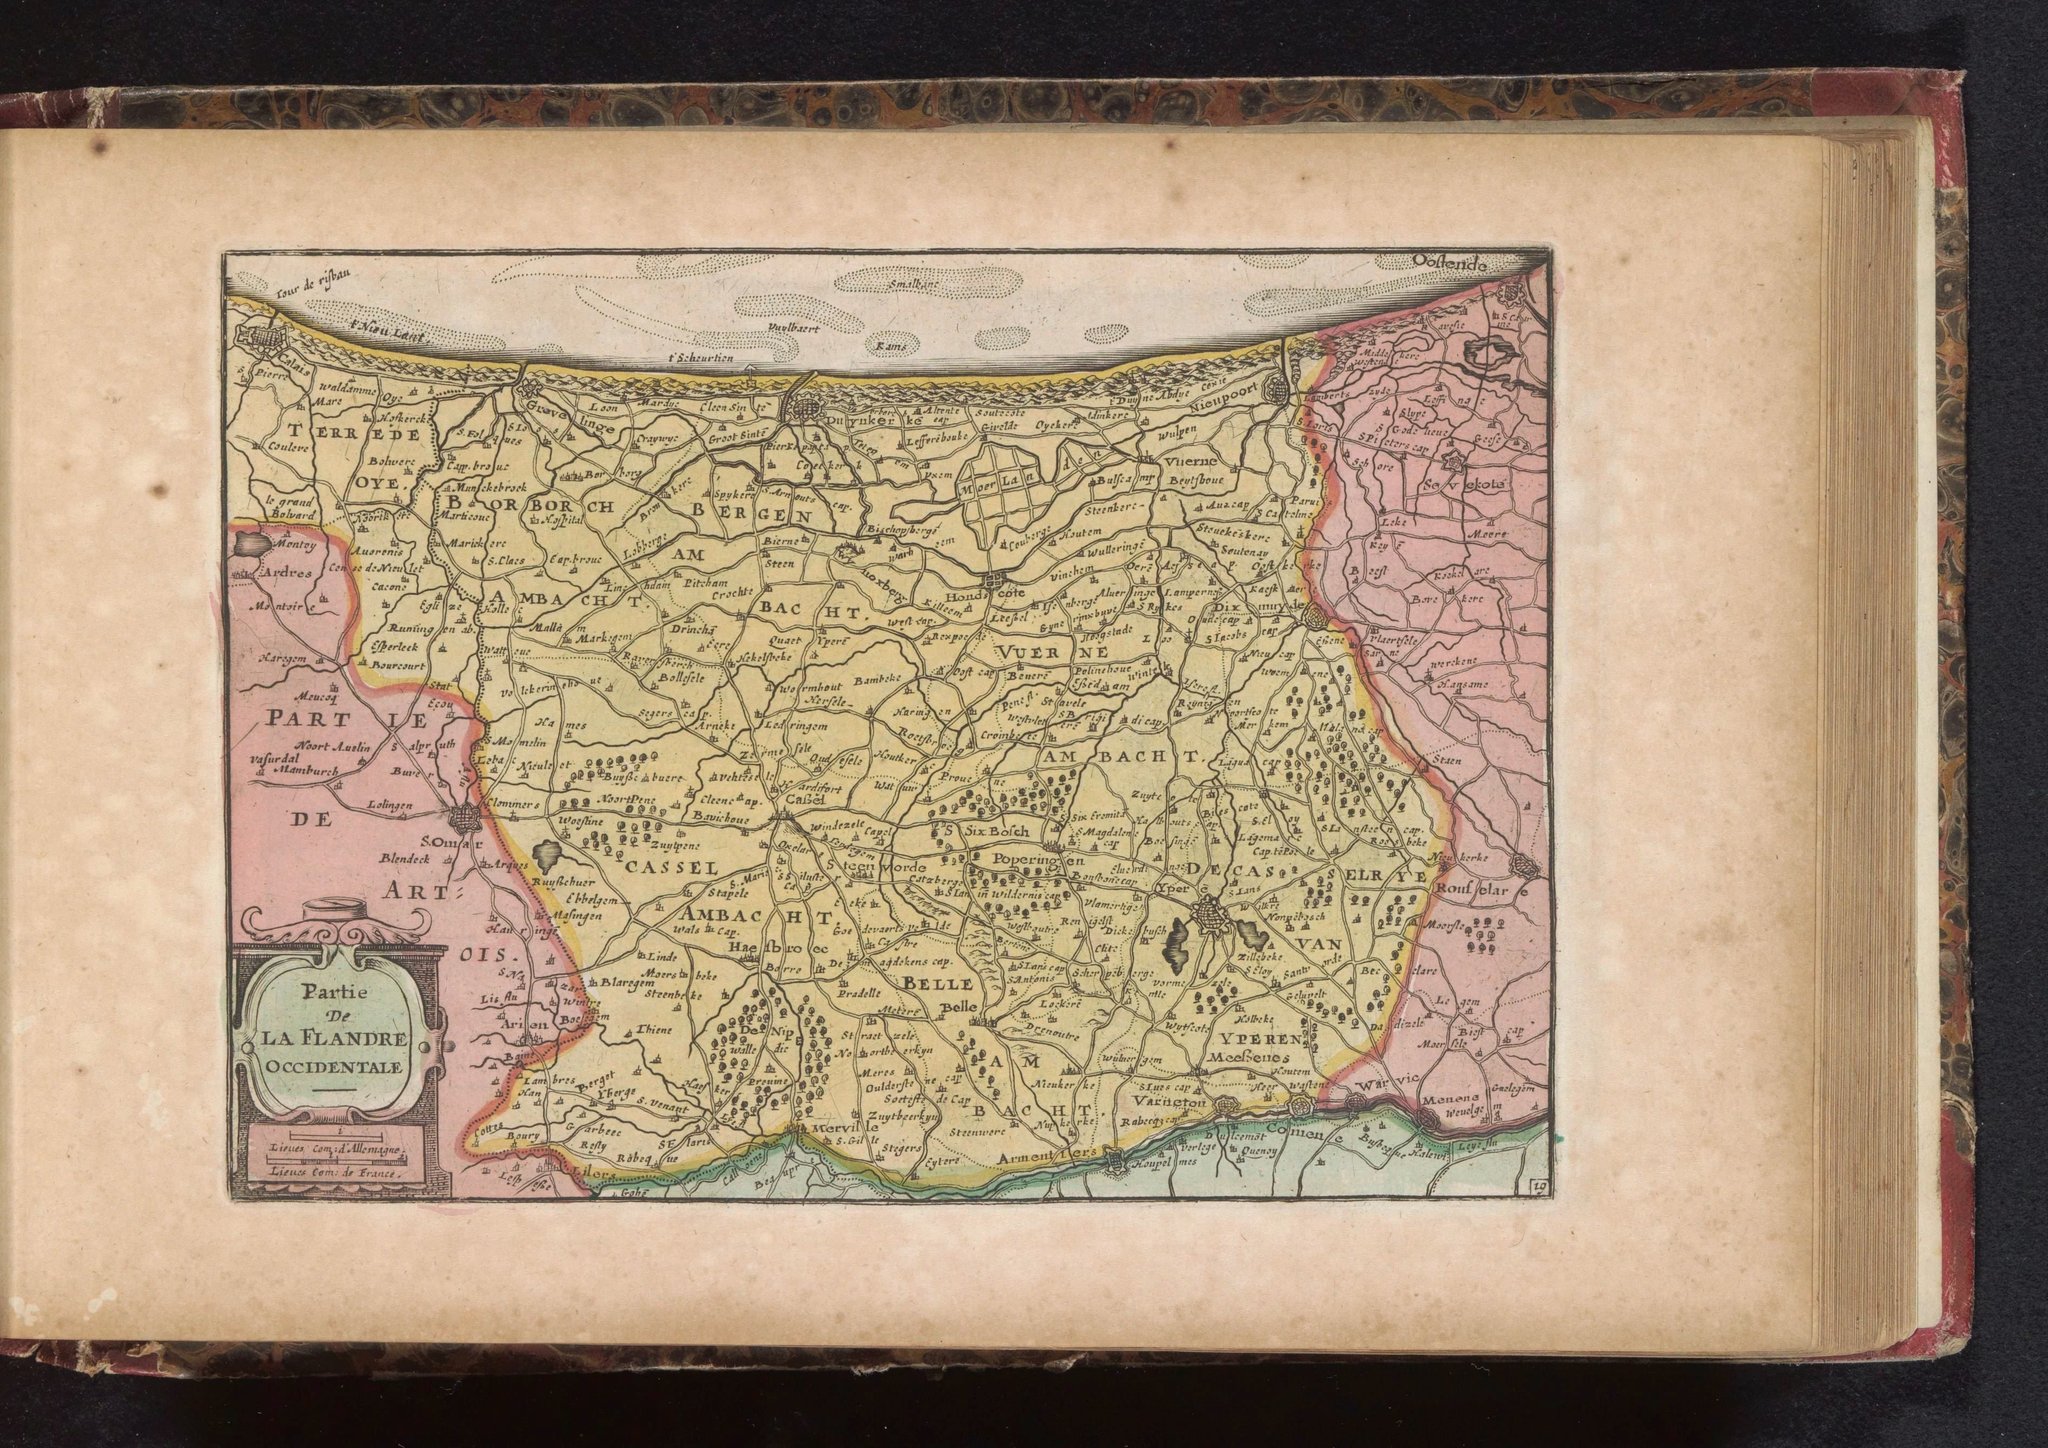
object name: map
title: Partie de la Flandre Occidentale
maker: Anonymous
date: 1700-1702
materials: paper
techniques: engraving, hand coloring, lacquer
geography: amsterdam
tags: maps of separate countries or regions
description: Kaart van West-Vlaanderen, bovenaan Duinkerke. Onderdeel van een atlas met 223 kaarten van landen en steden en oorlogstaferelen in Europa in de periode ca. 1690-1735.